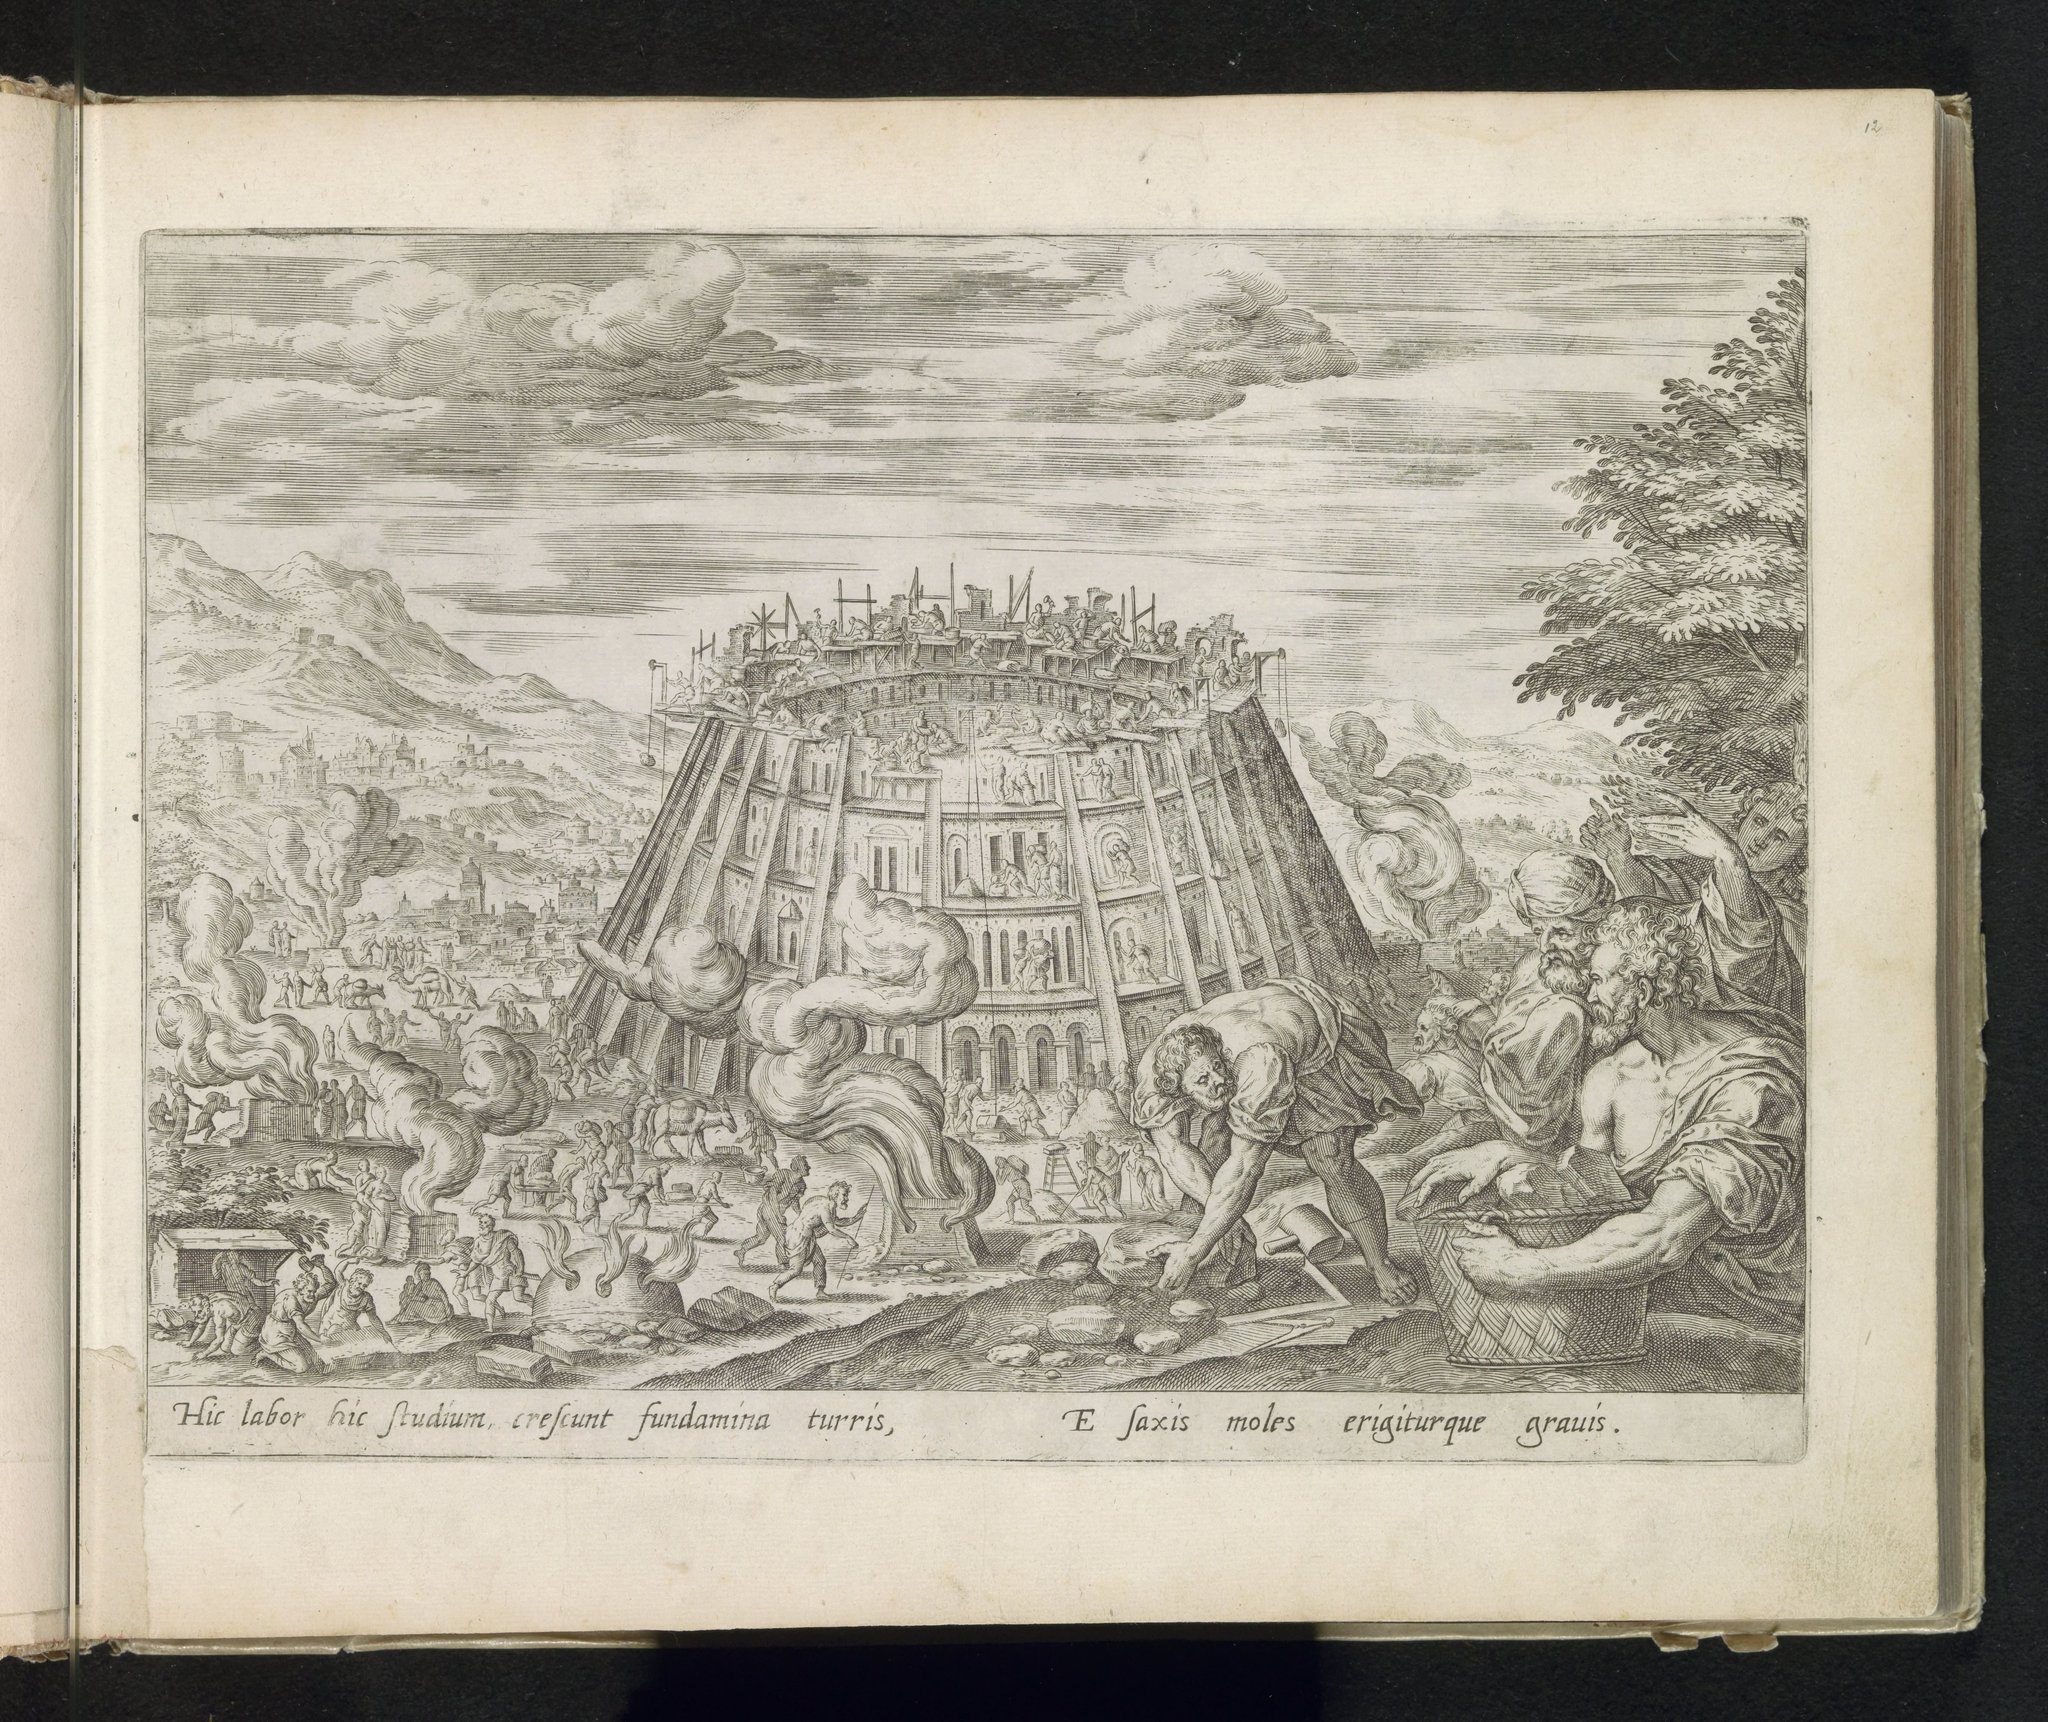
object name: print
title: Thesaurus sacrarum historiaru[m] veteris testame[n]ti, elega[n]tissimis imaginibus expressu[m] excelle[n]tissimoru[m] in hac arte viroru[m] opera: nu[n]c primu[m] in luce[m] editus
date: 1585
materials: paper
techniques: engraving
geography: antwerp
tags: the building of the tower of babel; nimrod may be present, supervising or assisting the construction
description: De toren van Babel wordt gebouwd. Op de voorgrond mannen die stenen hakken en versjouwen in manden. Rechts maakt een man, wellicht Nimrod, een wijzend gebaar. Links bouwwerkzaamheden: stenen worden gehakt en vervoerd met ezels, ovens worden gestookt. Onder de voorstelling een tekst in het Latijn. Deze prent maakt deel uit van een album.